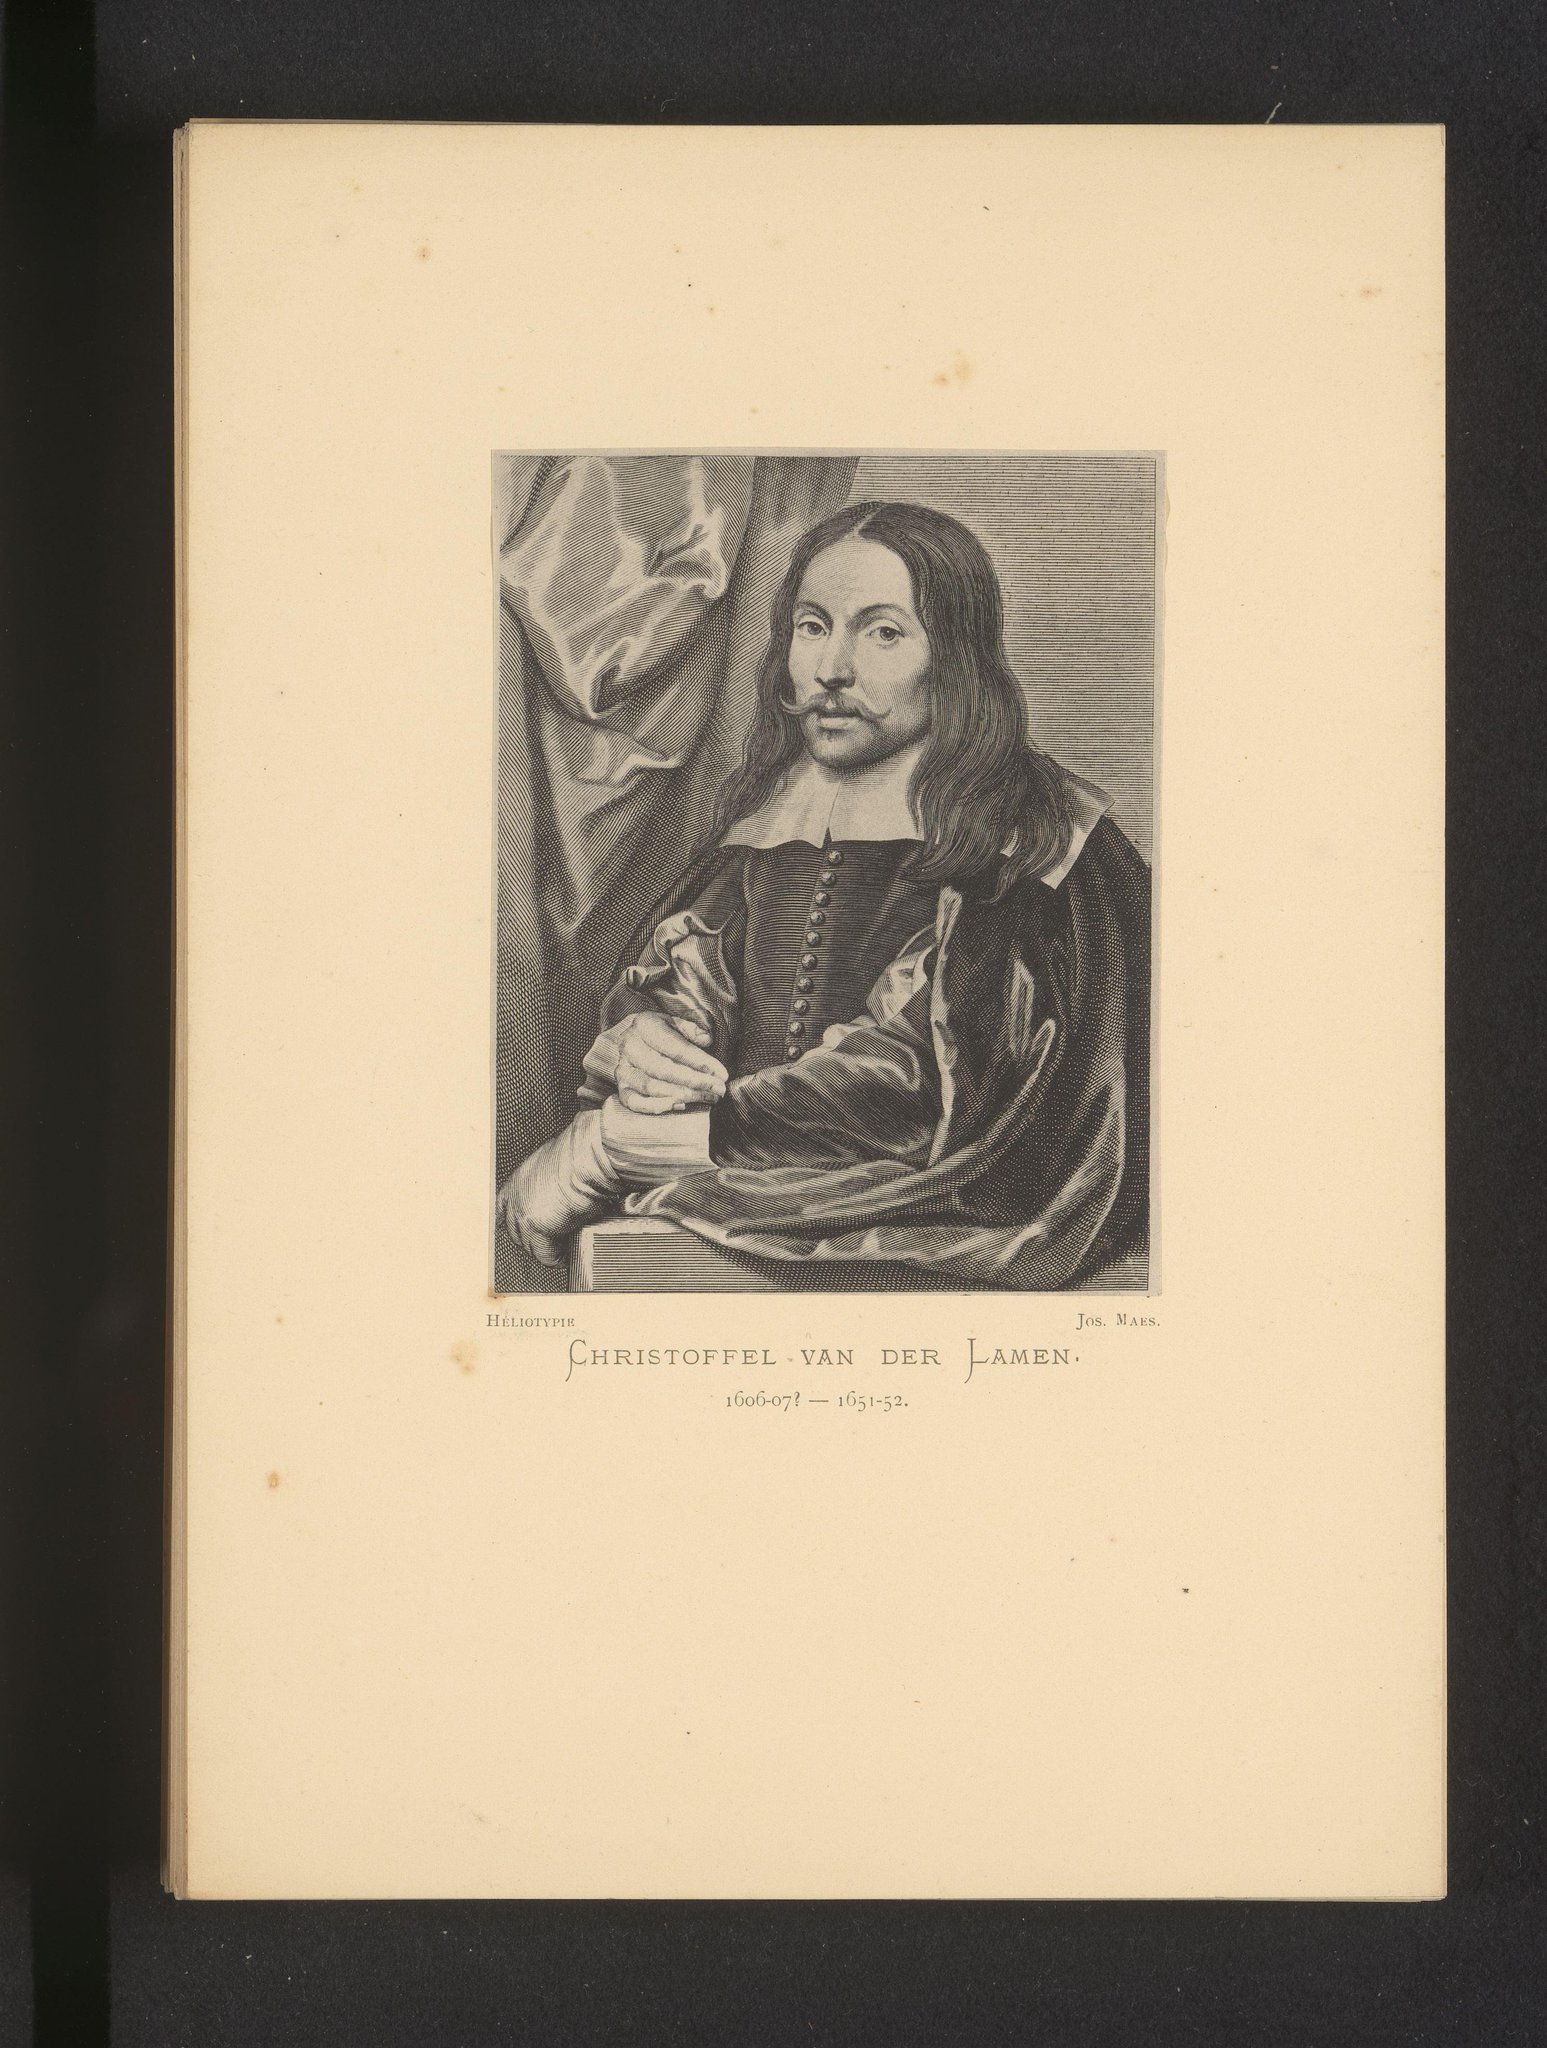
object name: photomechanical print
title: Christoffel van der Lamen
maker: joseph maes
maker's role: fotograaf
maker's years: 1838-1908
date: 1872-1877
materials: cardboard, paper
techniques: photograph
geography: antwerp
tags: painter, christoffel van der lamen, historical persons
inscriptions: inscription: ‘1606-07? - 1651-52.’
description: Deze prent maakt deel uit van een omslag met 150 prenten en een katern met een lijst van afbeeldingen.